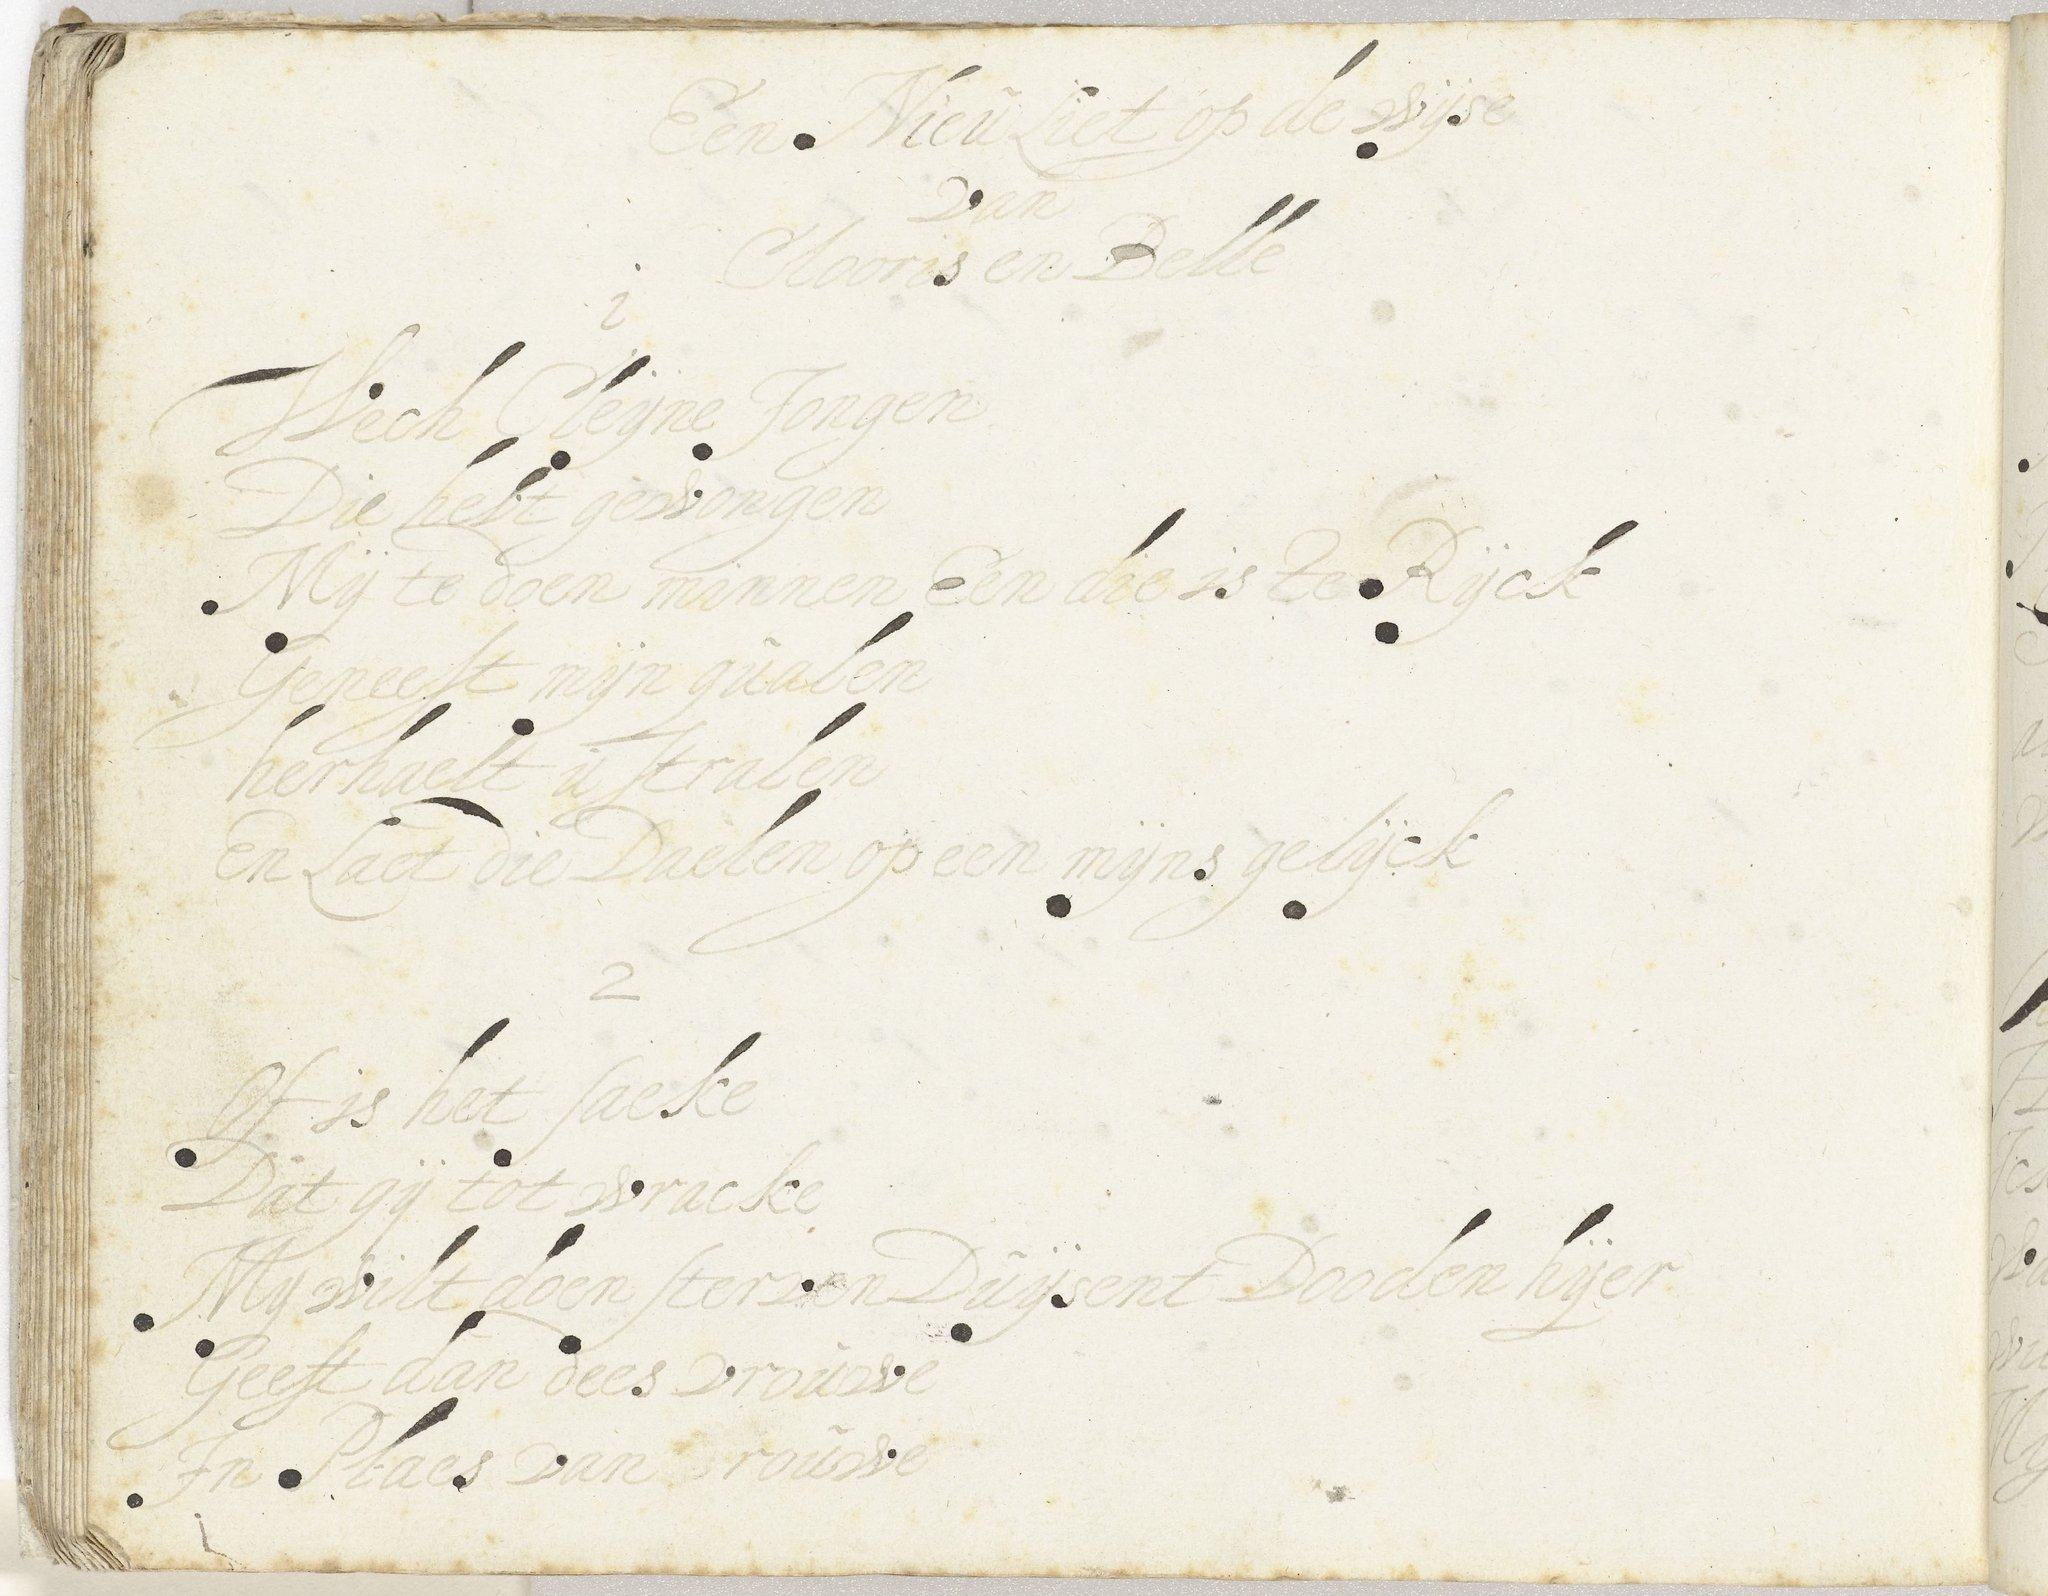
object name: calligraphy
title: Een Nieu Liet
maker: gesina ter borch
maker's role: draughtsman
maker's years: 1633-1690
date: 1646-1650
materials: ink, paper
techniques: calligraphy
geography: zwolle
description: Liefdesklacht op de melodie van Clooris en Belle.